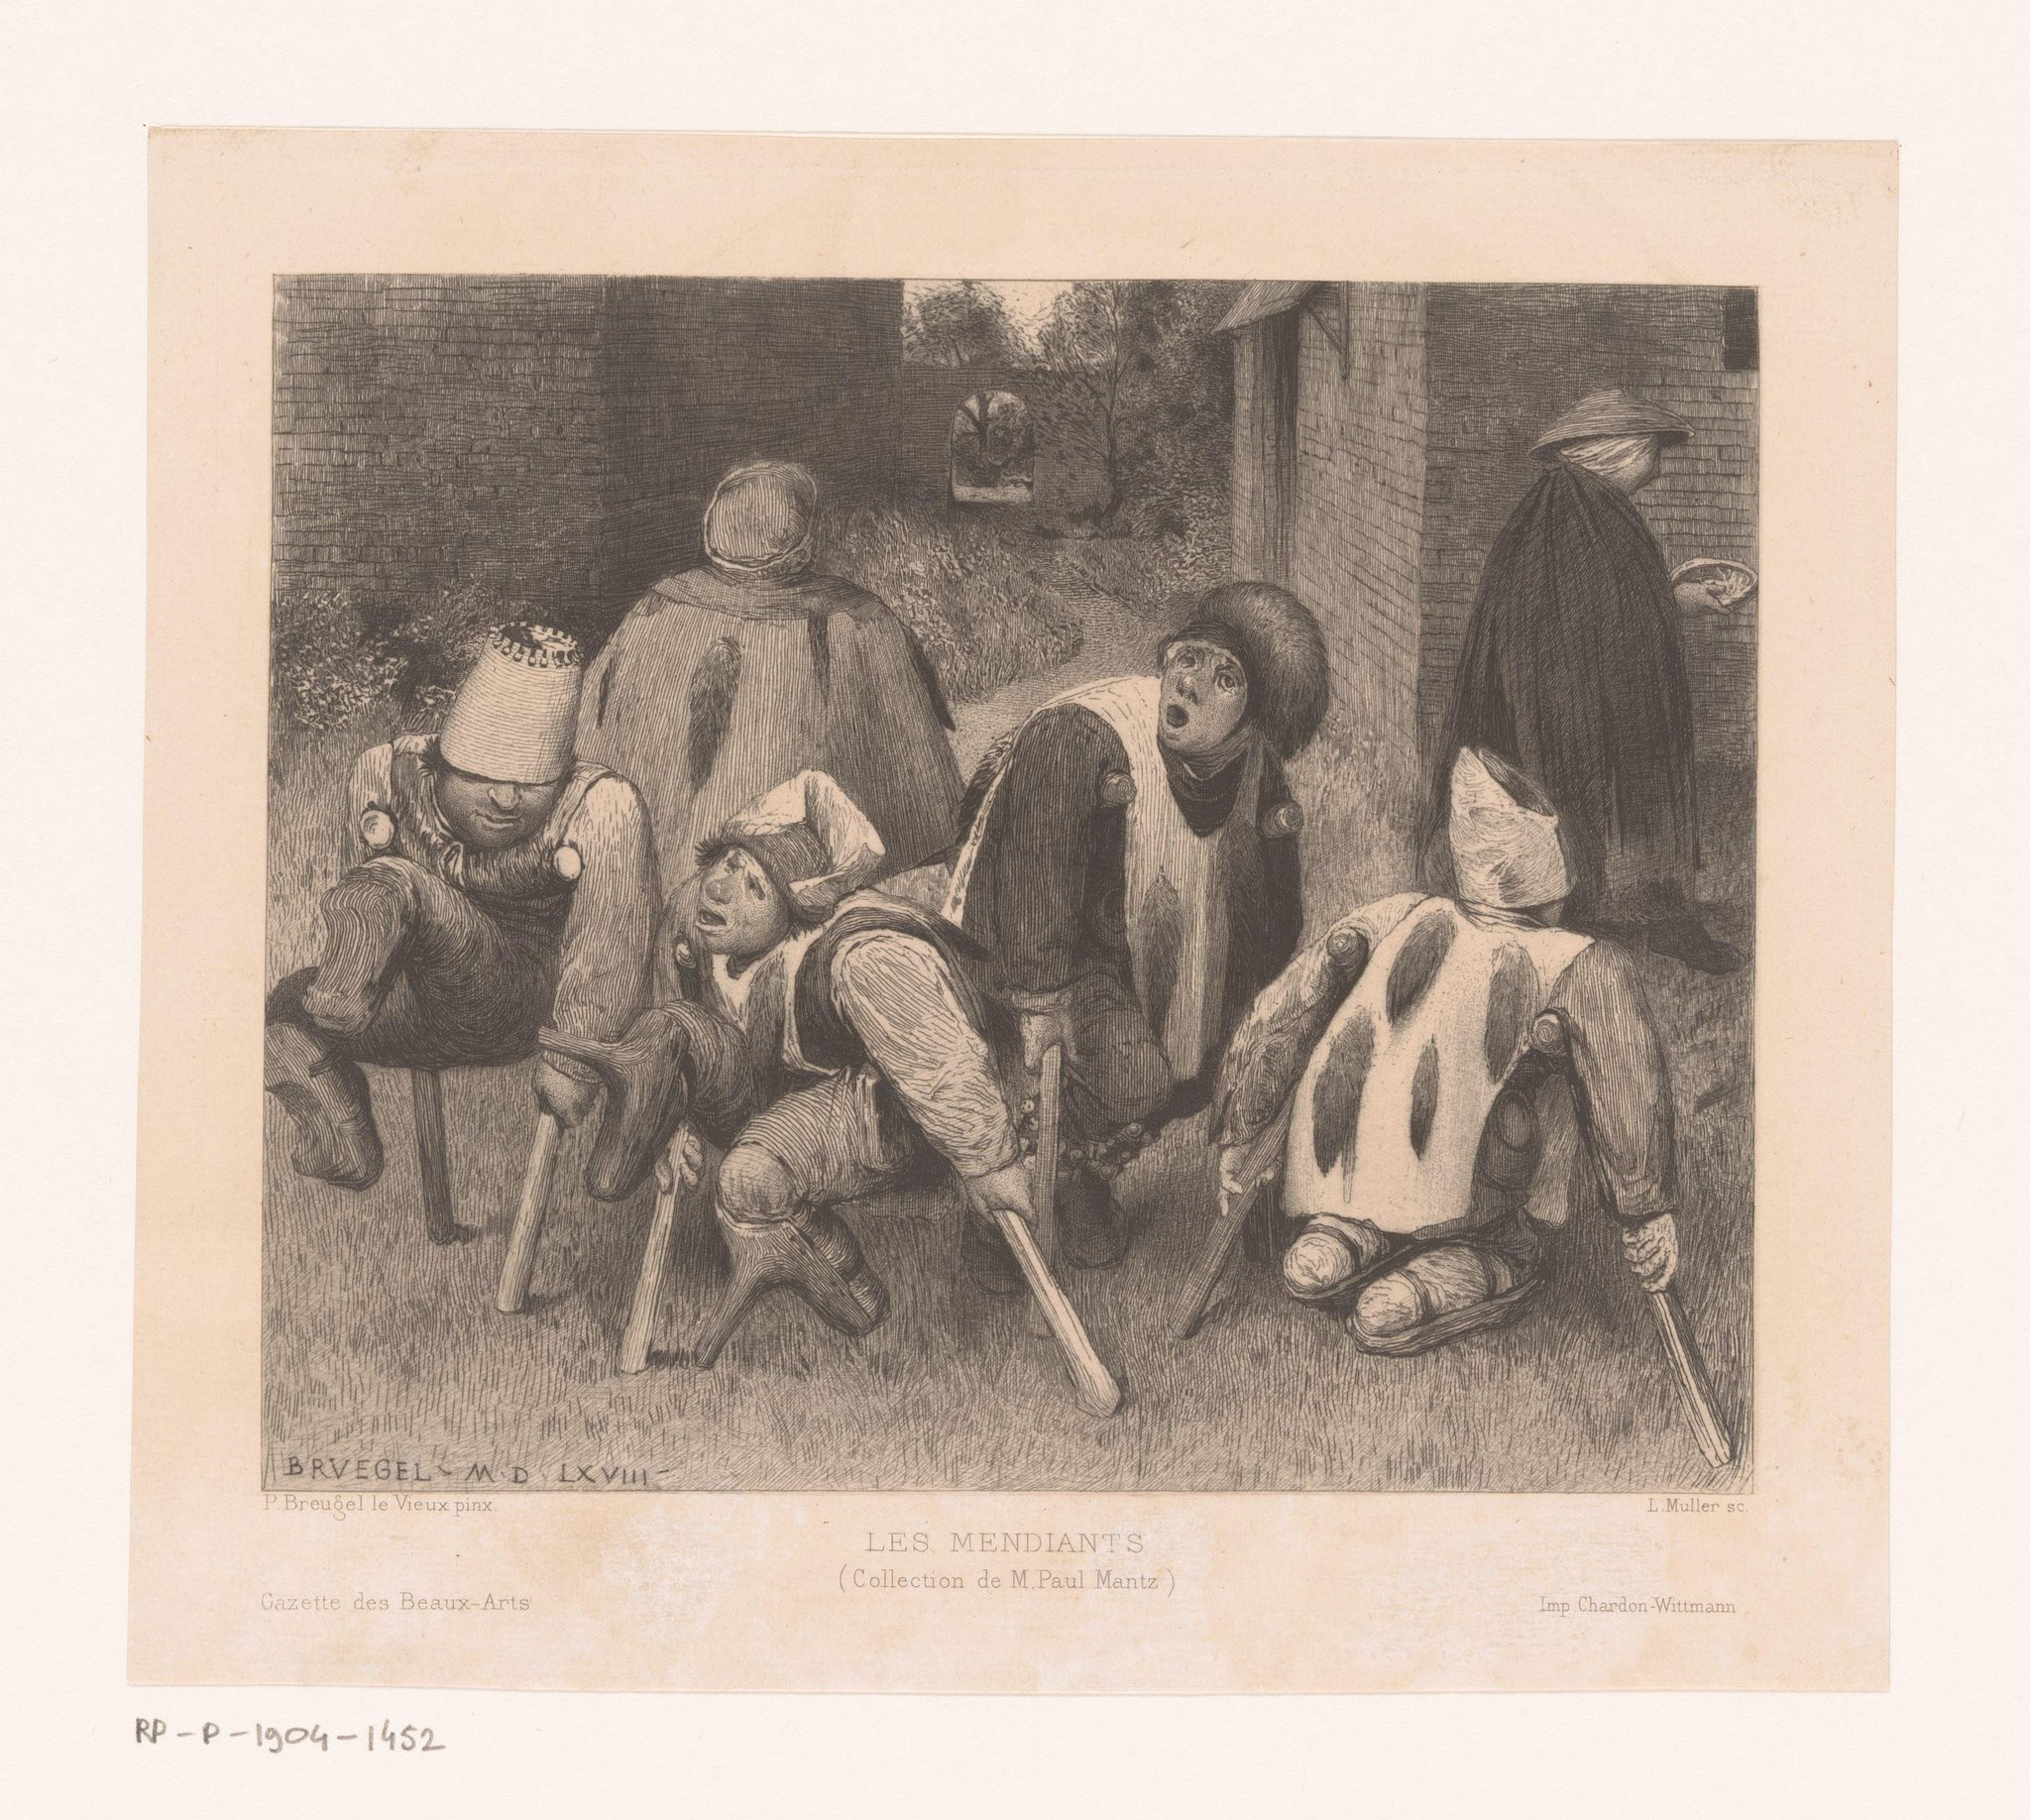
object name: print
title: Bedelaars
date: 1874-1900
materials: paper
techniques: etching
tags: person with a physical disability, beggar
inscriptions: collector's mark: Lugt 2228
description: Gepubliceerd in het Gazette des Beaux-Arts. Het schilderij bevindt zich in de collectie van het Musée du Louvre te Parijs, inv.nr. R.F.730.